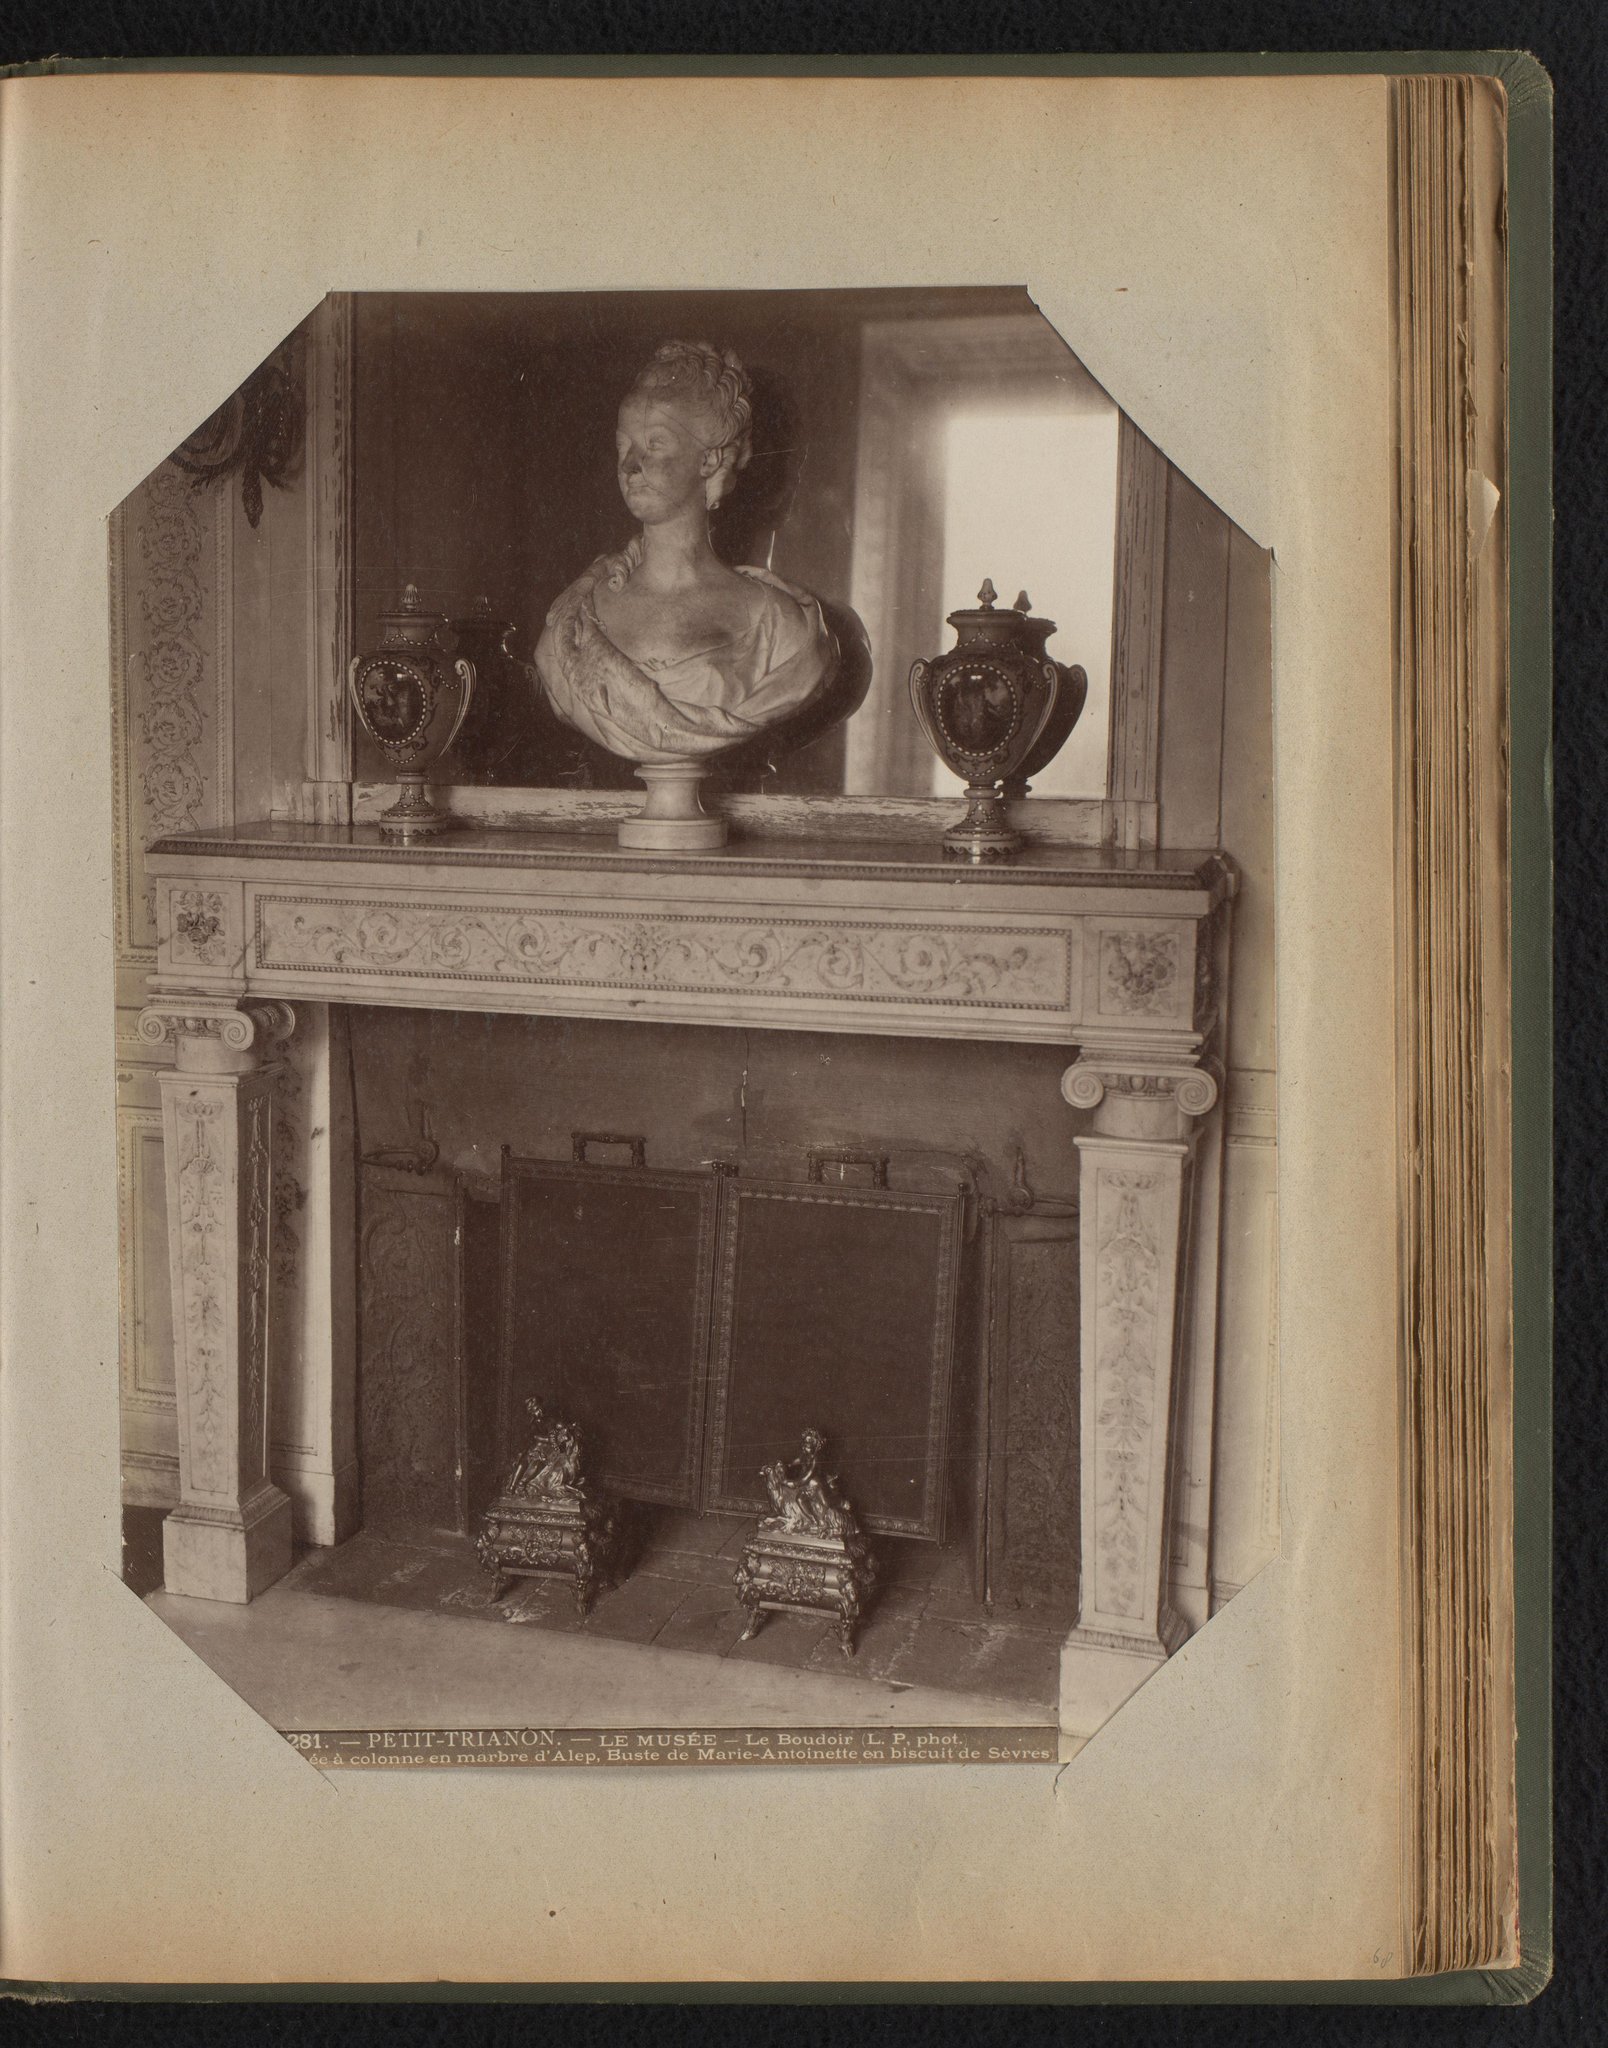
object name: photograph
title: 65. -Versailles - Petit Trianon - Le Musee - Le boudoir (L.P. Phot) Cheminee a colonne en marbre d'Alep. Buste de Marie - Antoinette en buiscuit de Sevres.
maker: Anonymous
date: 1860-1900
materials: paper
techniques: albumen print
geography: france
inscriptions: annotation: ‘65. -Versailles - Petit Trianon - Le Musee - Le boudoir (L.P. Phot) Cheminee a colonne en marbre d'Alep. Buste de Marie - Antoinette en buiscuit de Sevres.’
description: Onderdeel van een serie met betrekking tot het interieur van het paleis van Versailles met kroonluchters, deuren, portalen en meubelstukken.